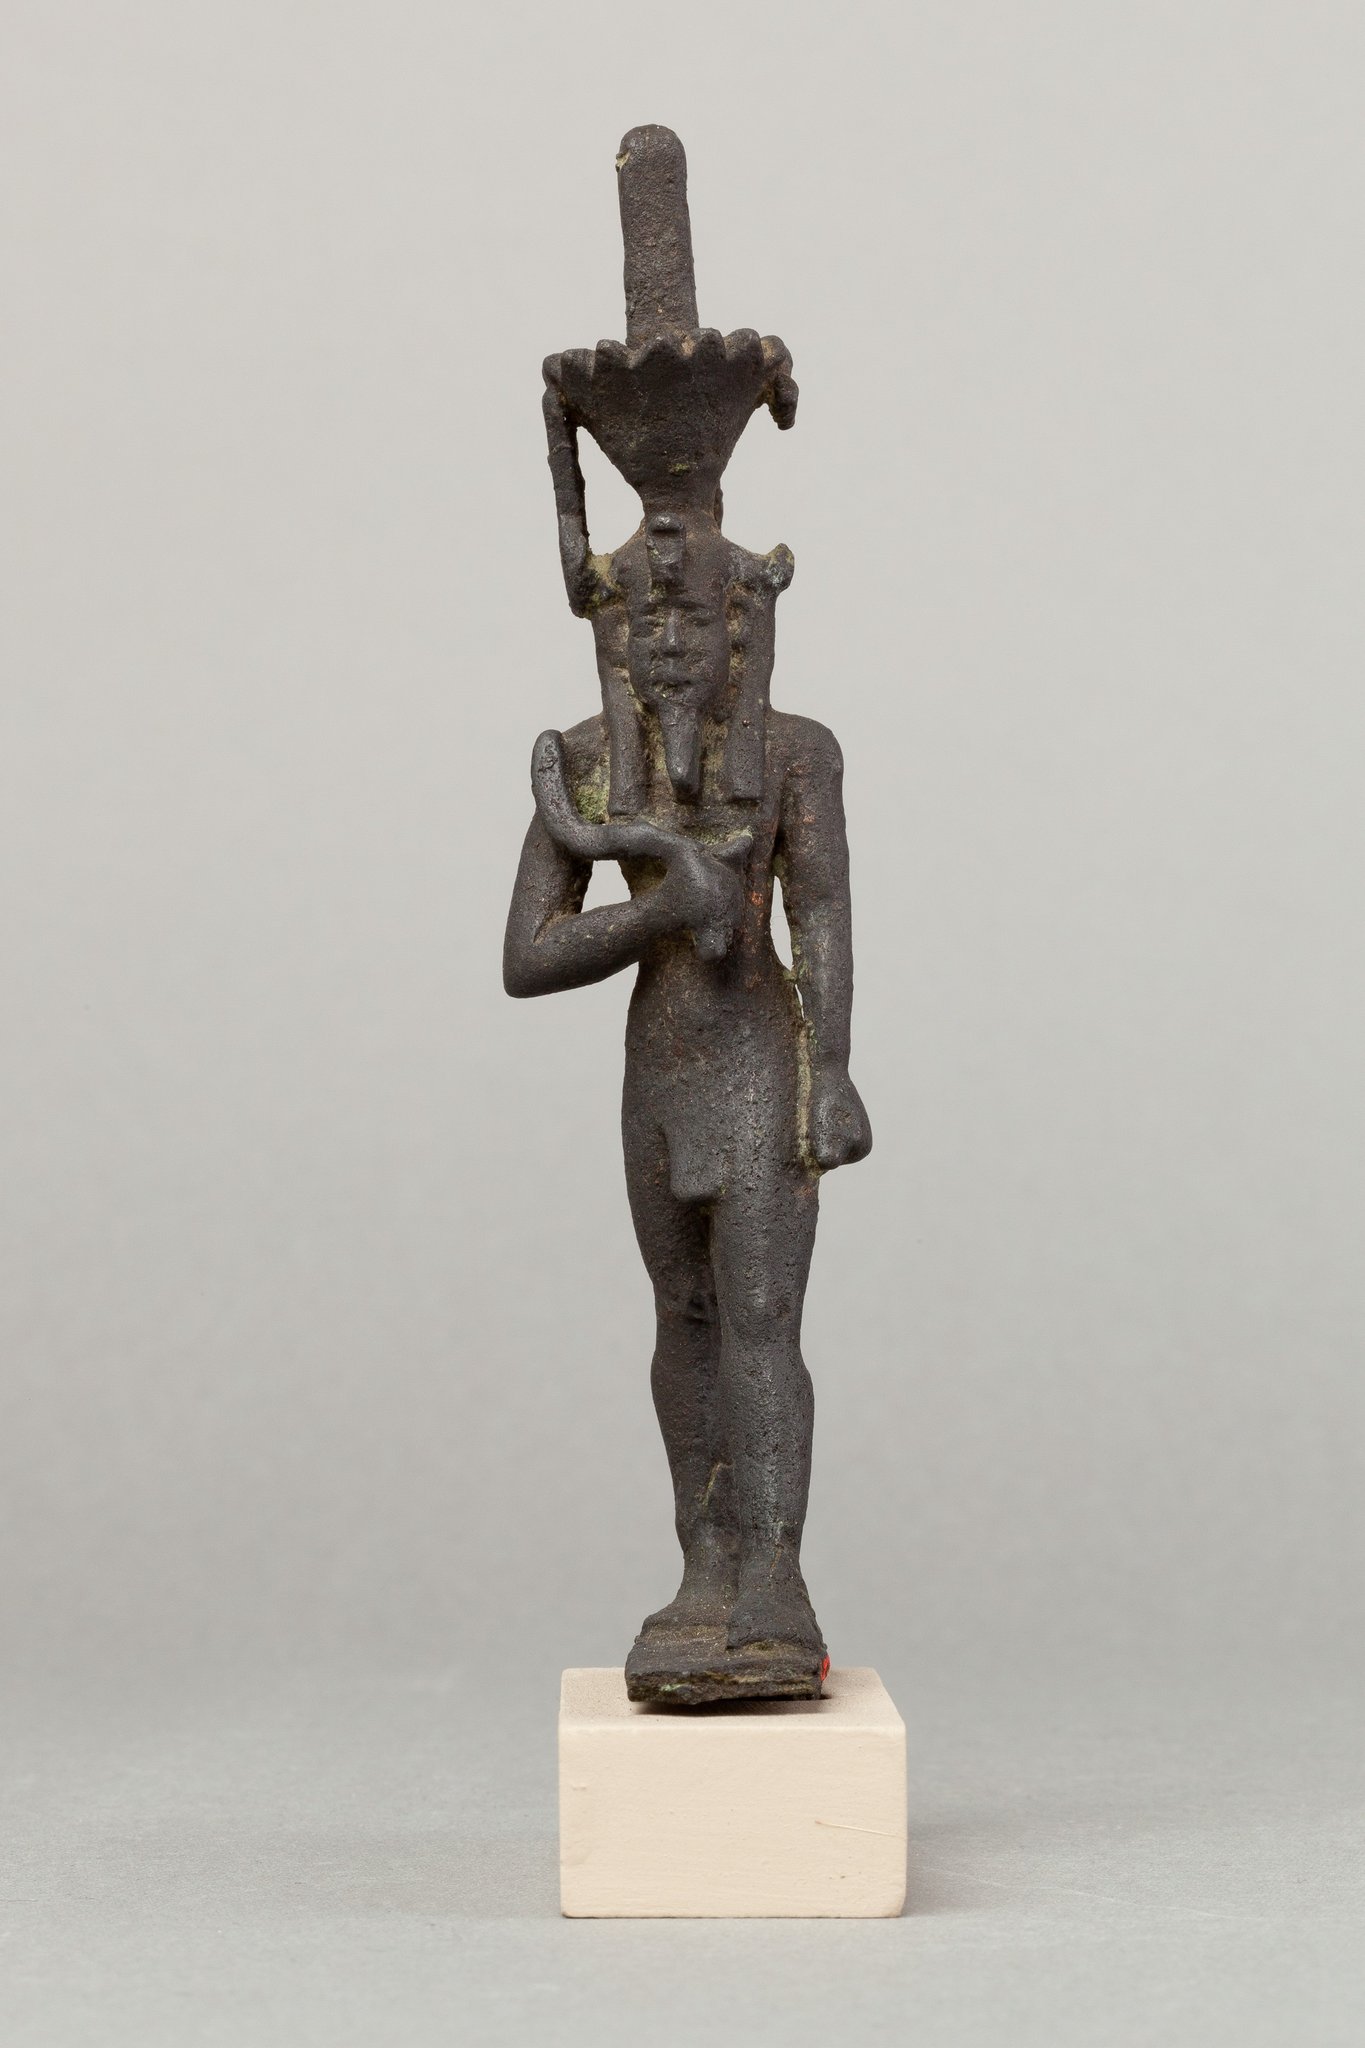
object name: statuette, nefertum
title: Nefertum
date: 664-630 BCE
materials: metal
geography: egypt